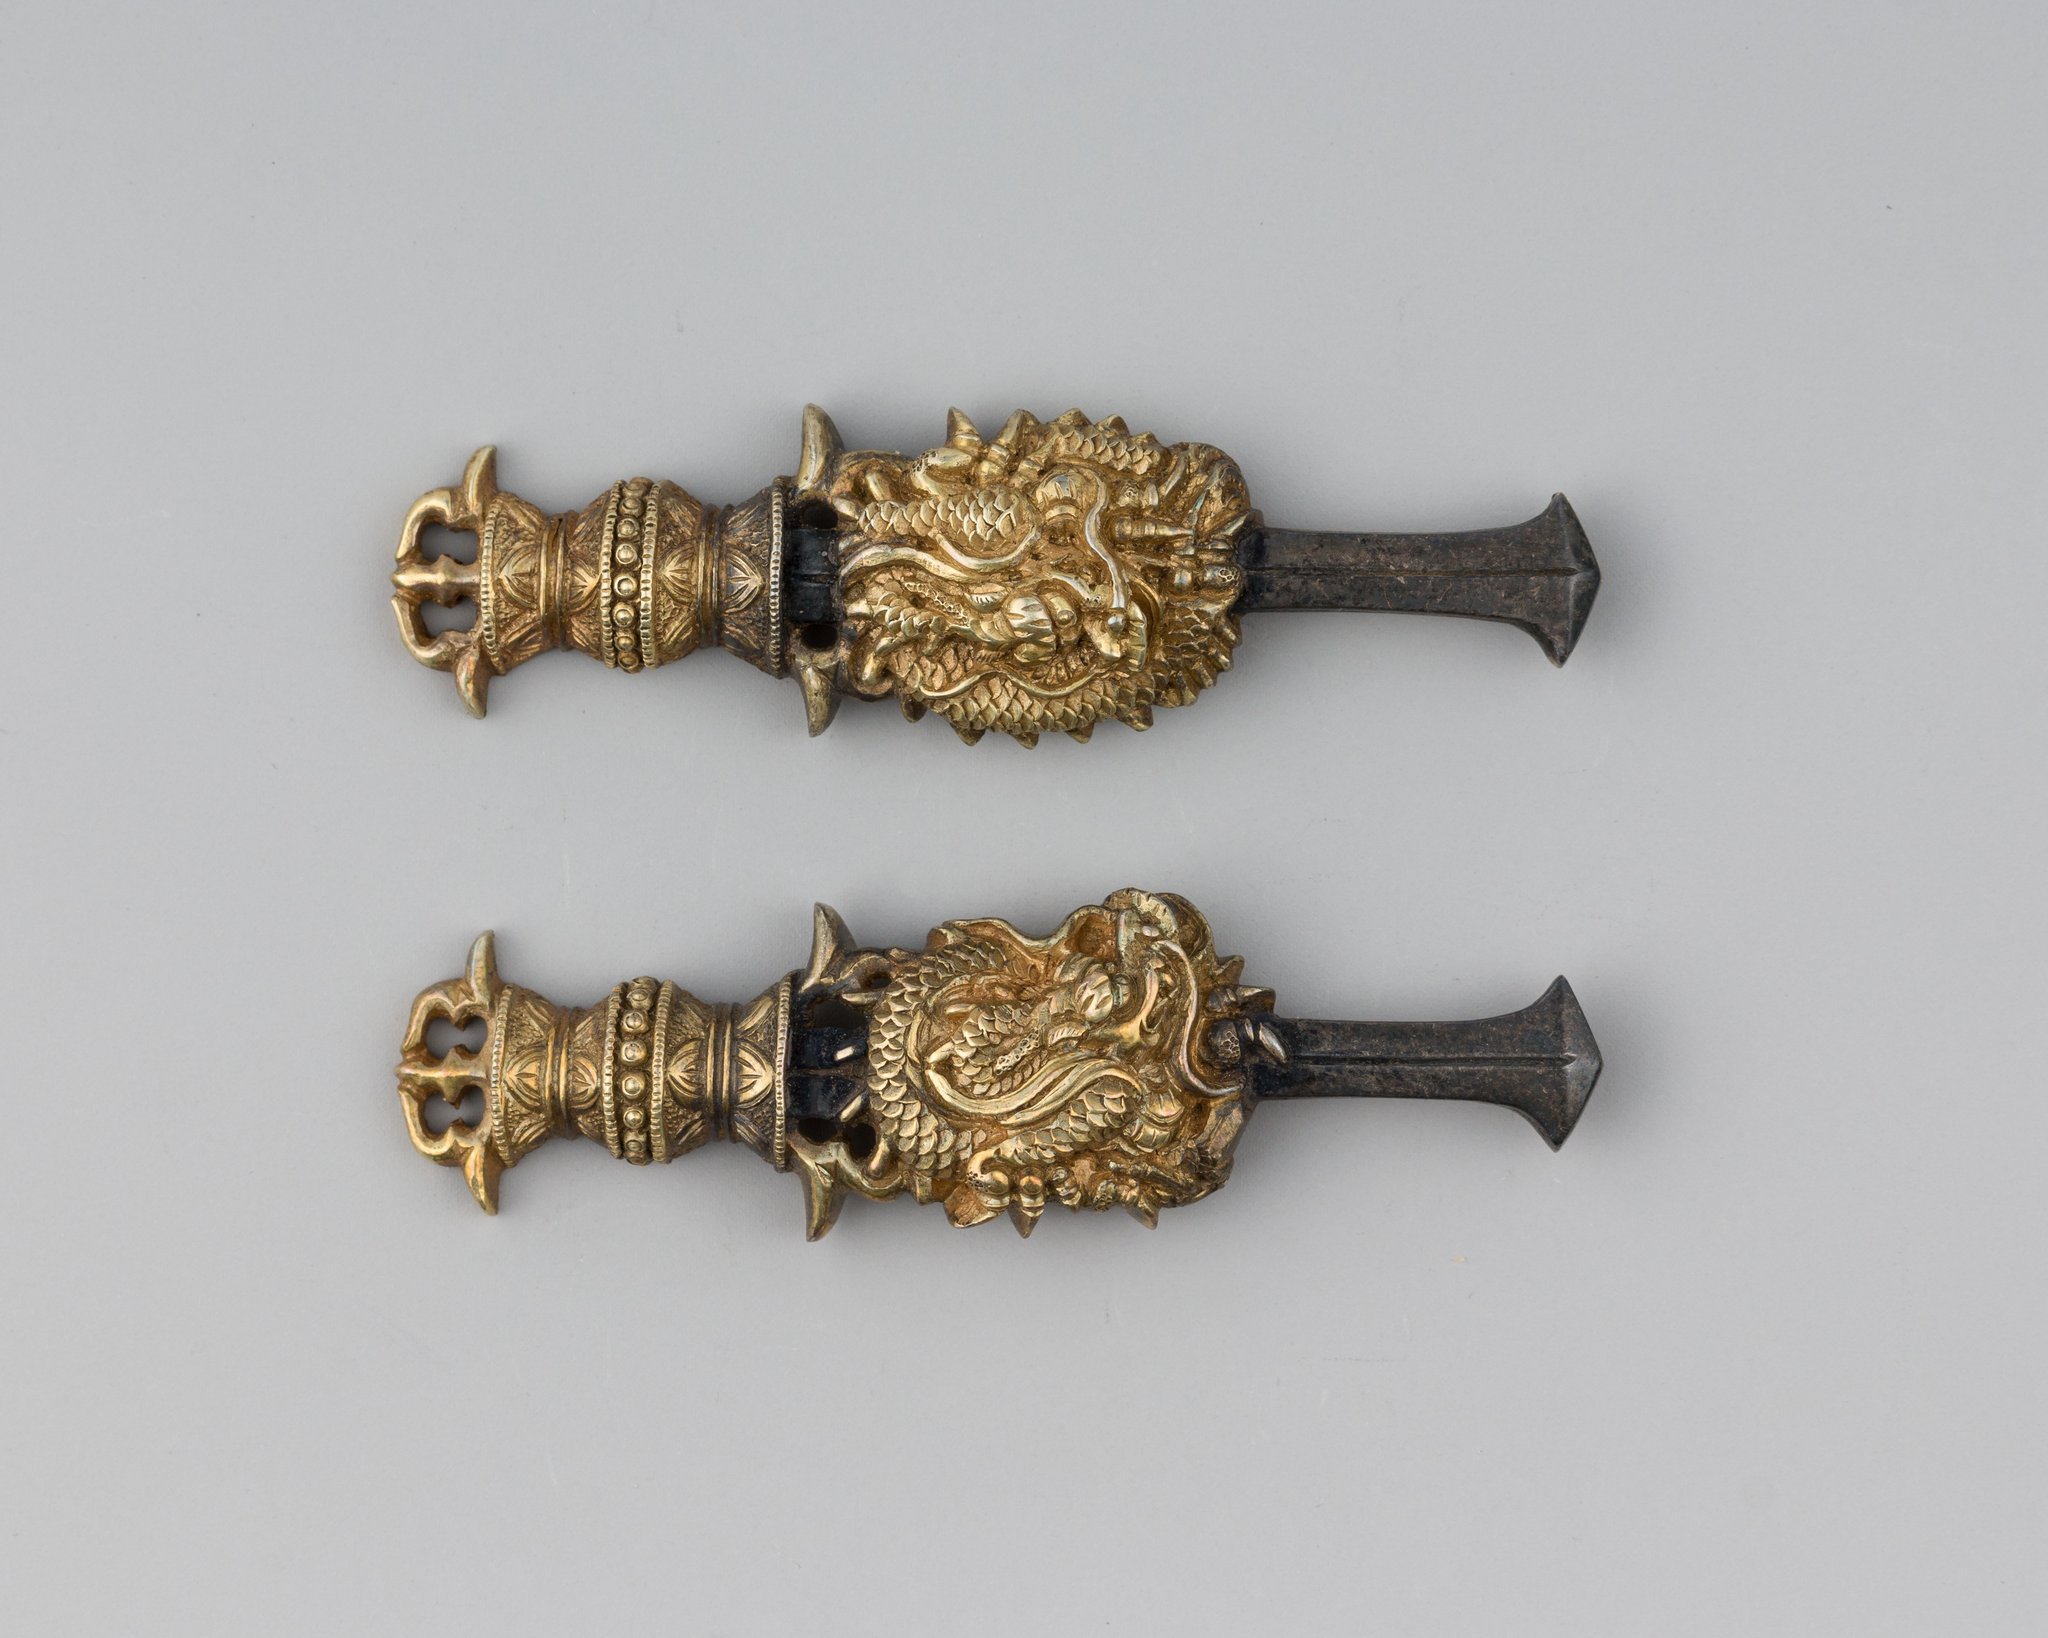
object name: pair of sword grip ornament menuki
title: Pair of Sword-Grip Ornaments (Menuki)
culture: japanese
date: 1701-1800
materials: gold, silver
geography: japan